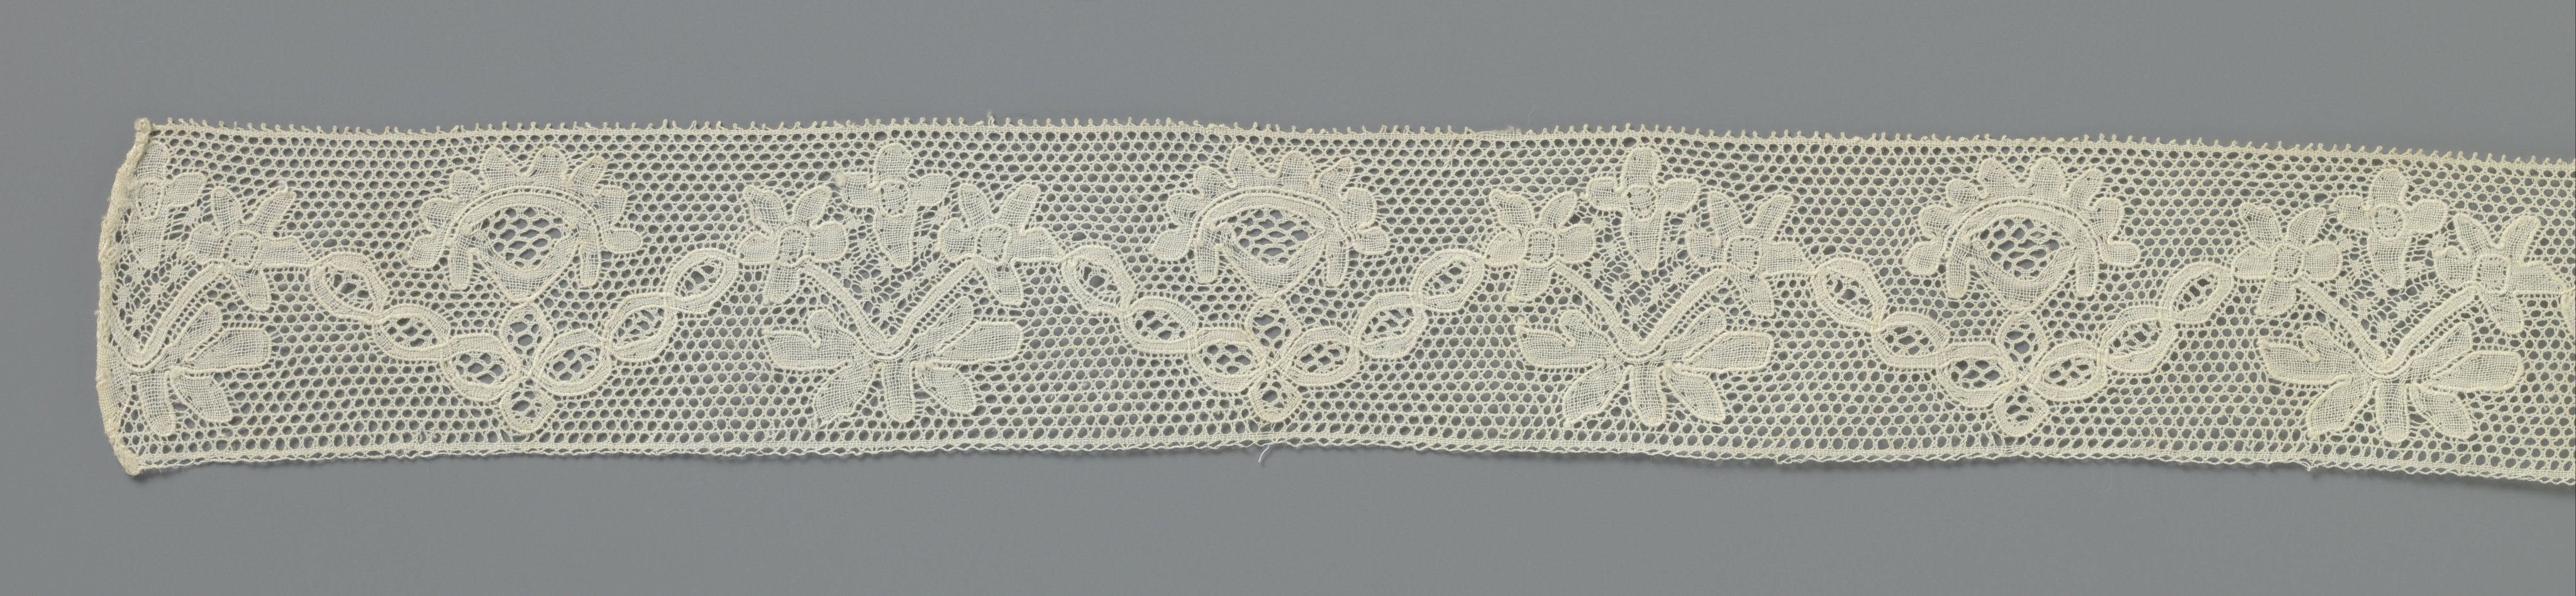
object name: strip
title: Strook kloskant met zigzag-slinger en driehoekig boeket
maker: Anonymous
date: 1800-1899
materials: linen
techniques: lace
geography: france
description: Strook naturelkleurige kloskant, Parijse kant. Het zich herhalende en doorlopende patroon bestaat uit een zigzag-slinger van aaneengeschakelde opengewerkte ovaaltjes met een waaierbloem en een v-vormig boeket met drie bloemen. De motieven zijn met elkaar verbonden door een maasgrond, een Parijse grond. De motieven zijn gemaakt in linnenslag met dikkere en glimmende contourdraden. Als siergrond is in de boeketten een sneeuwvlokkengrond toegepast en in de ovaaltjes en de waaierbloem een grovere maasgrond. Boven- en onderzijde zijn recht afgewerkt, waarbij de onderzijde is voorzien van picots. De korte zijden zijn afgewerkt met een zoompje.